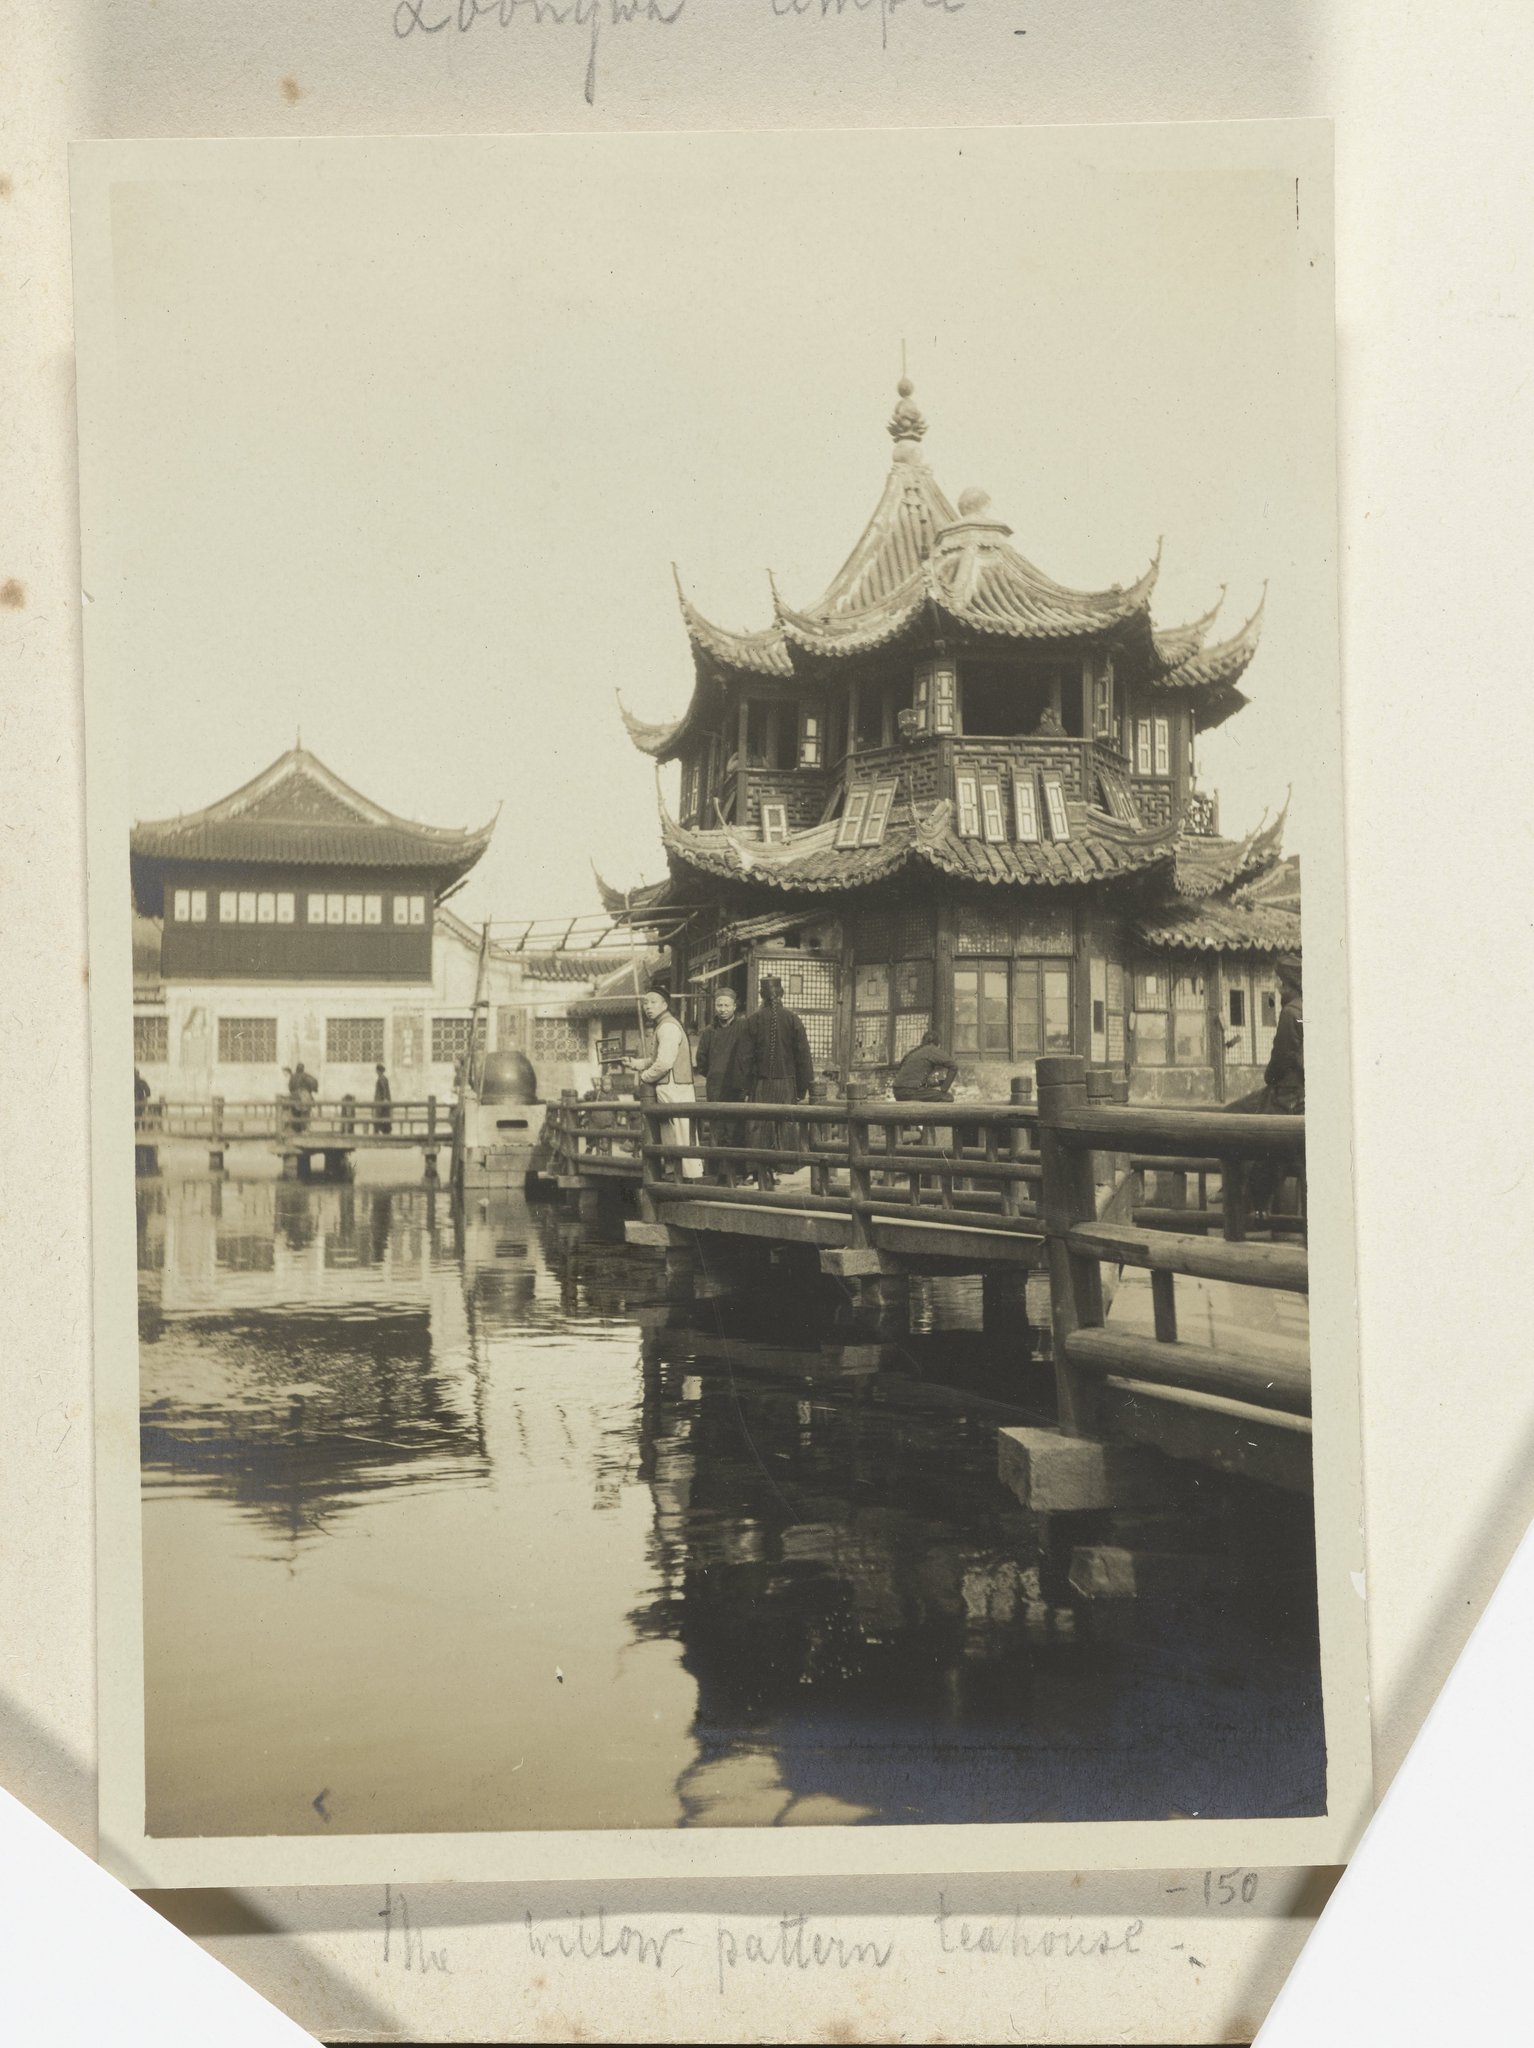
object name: photograph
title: The Willow pattern teahouse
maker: geldolph adriaan kessler (dolph)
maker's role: fotograaf, industrieel, voetballer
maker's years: 1884-1945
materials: cardboard, photographic support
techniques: gelatin silver print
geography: shanghai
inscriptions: title: ‘The Willow pattern teahouse’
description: Het Willow pattern teahouse in Shanghai. Onderdeel van het fotoalbum van Dolph Kessler met opnamen die hij maakte tijdens zijn verblijf in Engeland en op een wereldreis die hij als secretaris van Henri Deterding (directeur Koninklijke Olie) ondernam naar Nederlands-Indië, Japan, China en de Verenigde Staten, tussen 1906 en 1908.